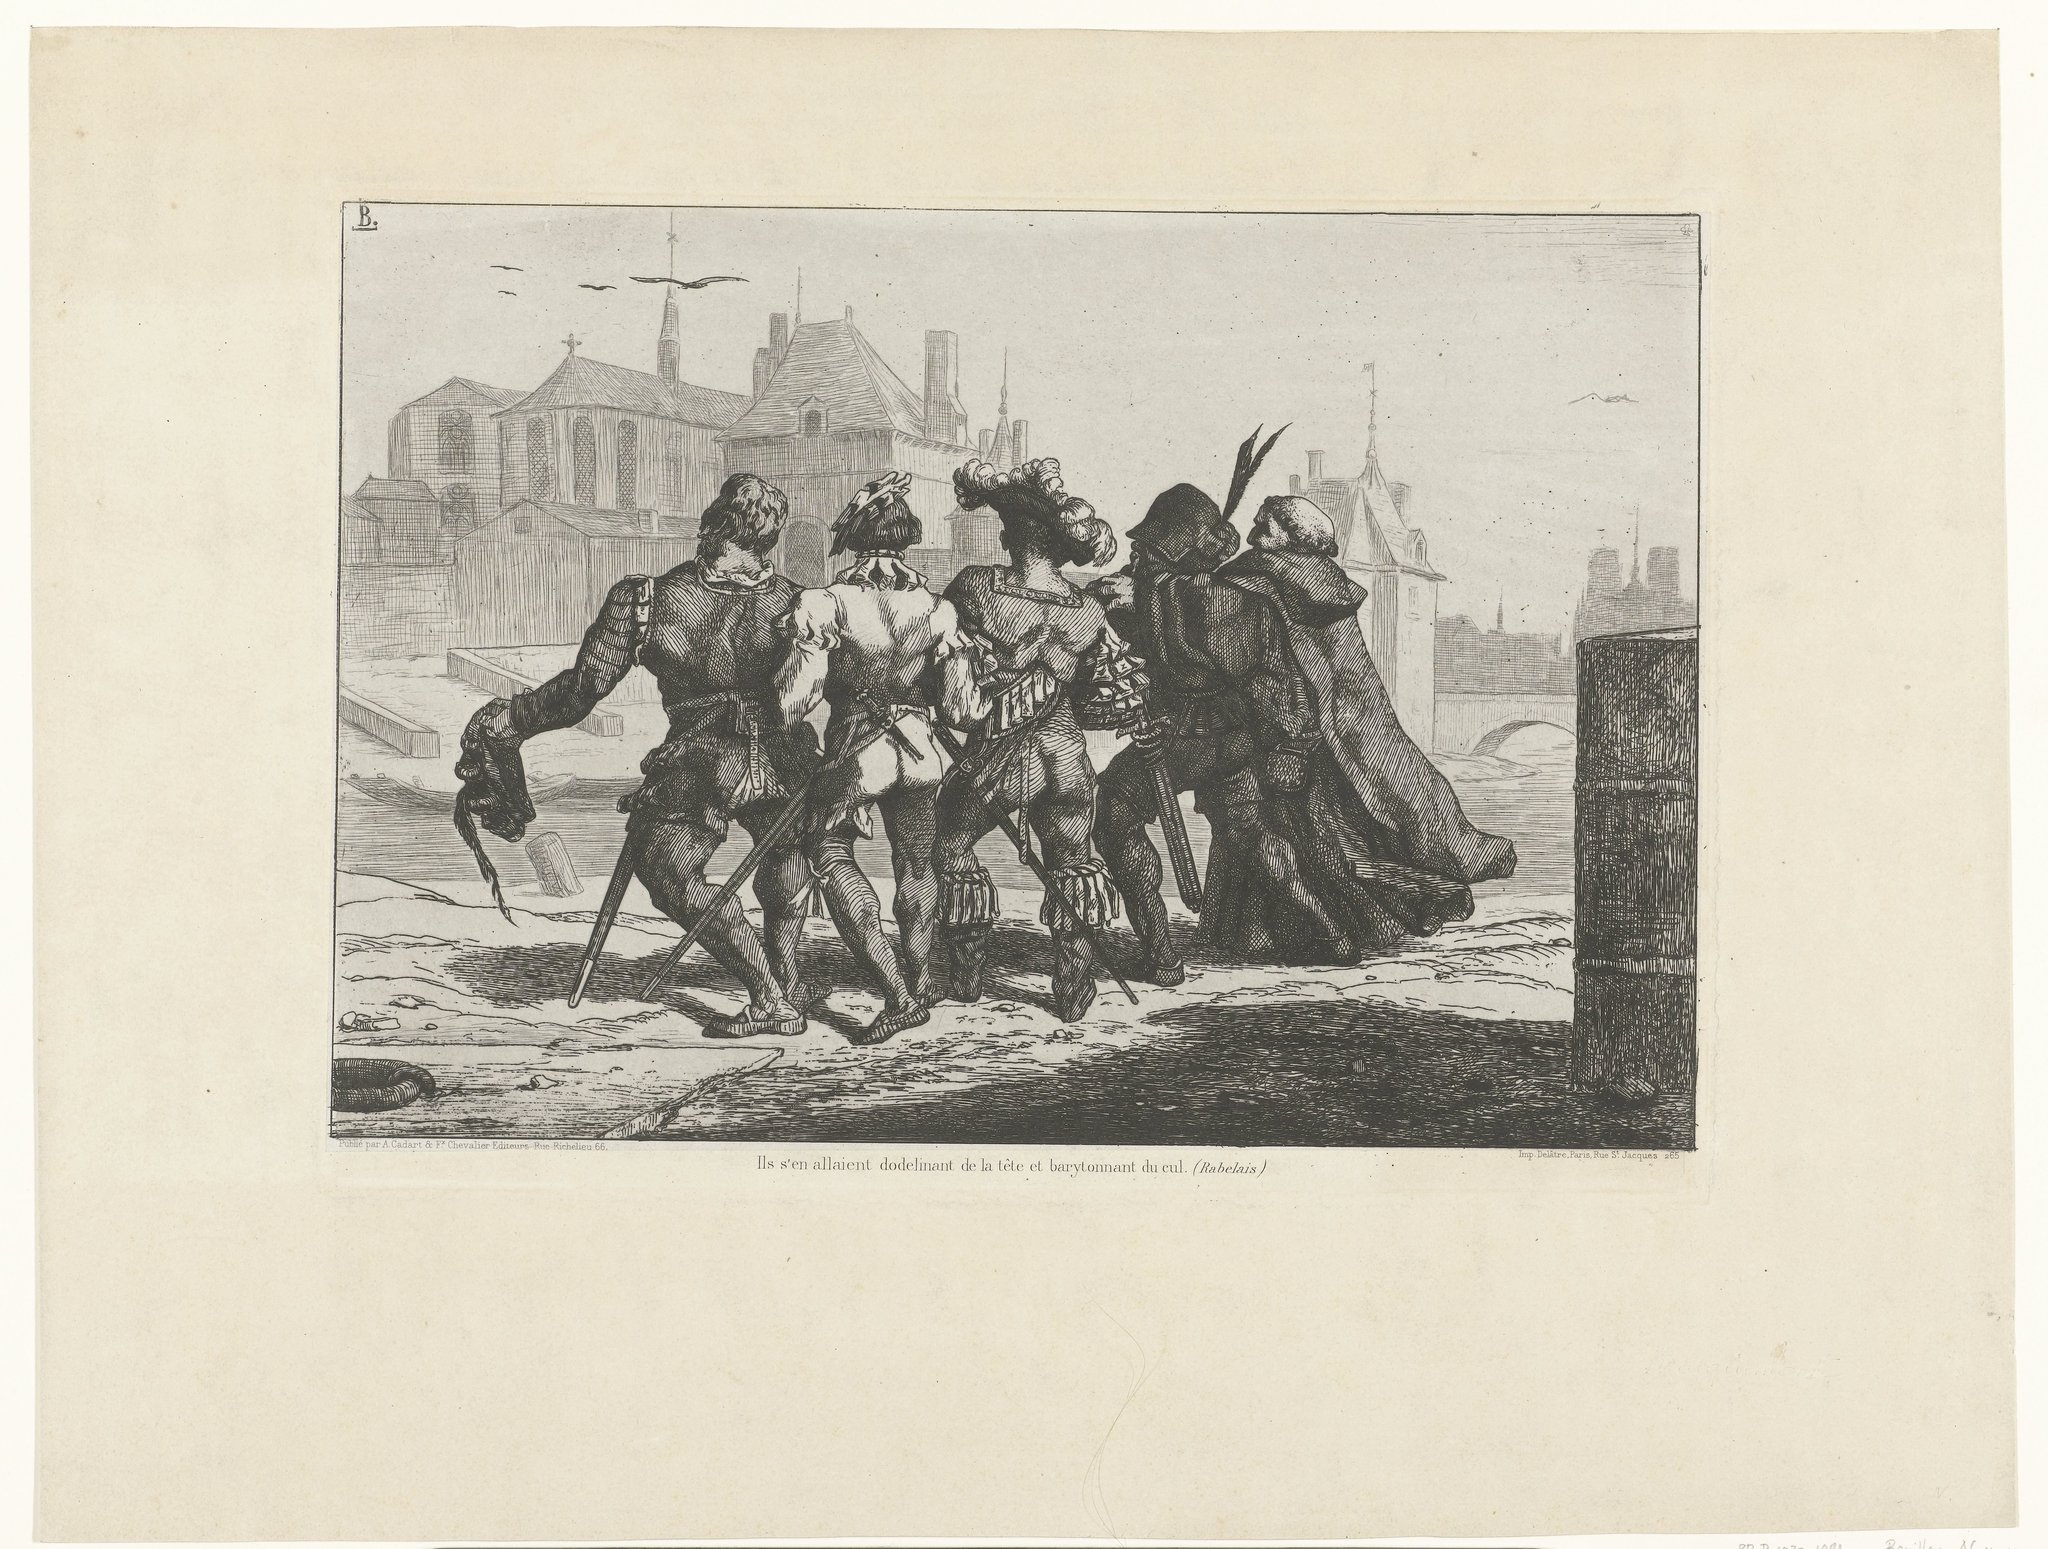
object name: print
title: Scène uit Pantagruel van Rabelais waarin vijf mannen, Ponocrates, Panurge, Epistémon, Gymnaste en Frère Jean, larm in arm lopen in Parijs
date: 1854-1855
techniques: printmaking, etching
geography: paris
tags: adult man, monk(s), friar(s), paris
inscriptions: collector's mark: Lugt 2233, collector's mark: Lugt 2760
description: Scène uit Pantagruel van Rabelais waarin vijf mannen, Ponocrates, Panurge, Epistémon, Gymnaste en Frère Jean, arm in arm lopen in Parijs. Volgens het onderschrift bewegen ze hun hoofden op en neer en zingen. Op de rug gezien en in oude kostuums is het een vreemd gezelschap waarin vooral de monnik opvalt. Rechts op de achtergrond tekent het silhouette van de Nortre Dame zich af tegen de hemel.